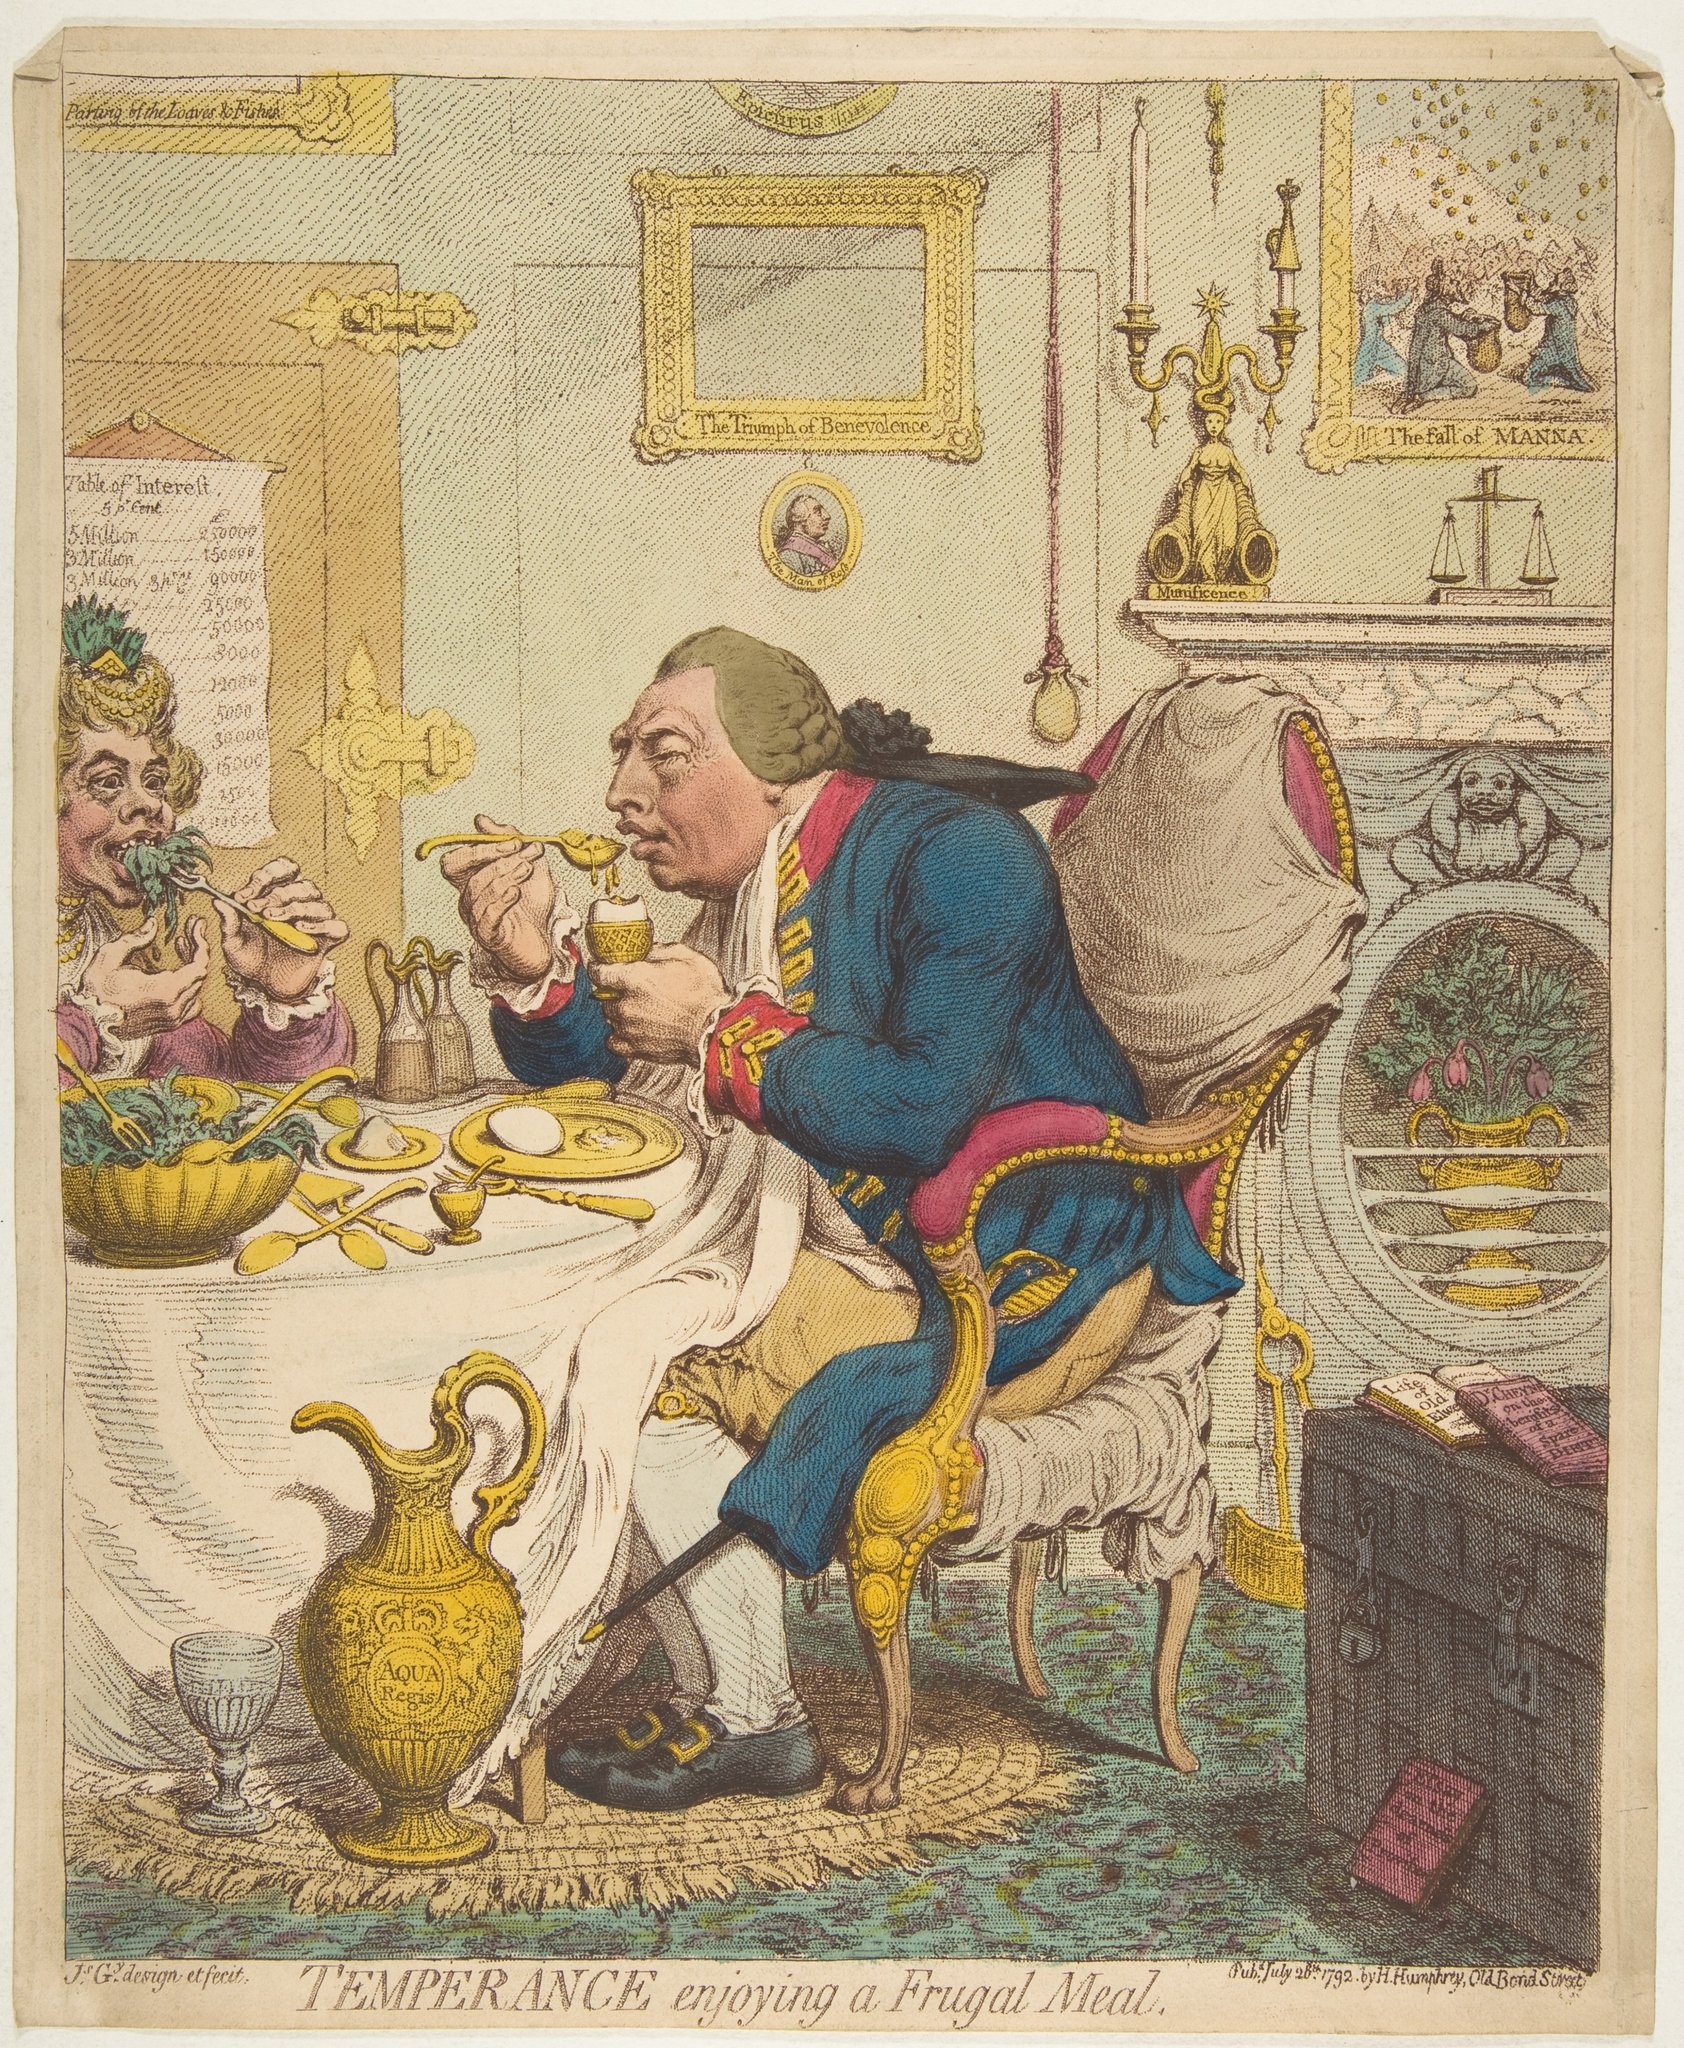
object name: print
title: Temperance Enjoying a Frugal Meal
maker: james gillray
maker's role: artist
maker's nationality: british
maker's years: 1756-1815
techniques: etching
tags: food,satire,men,women,dining